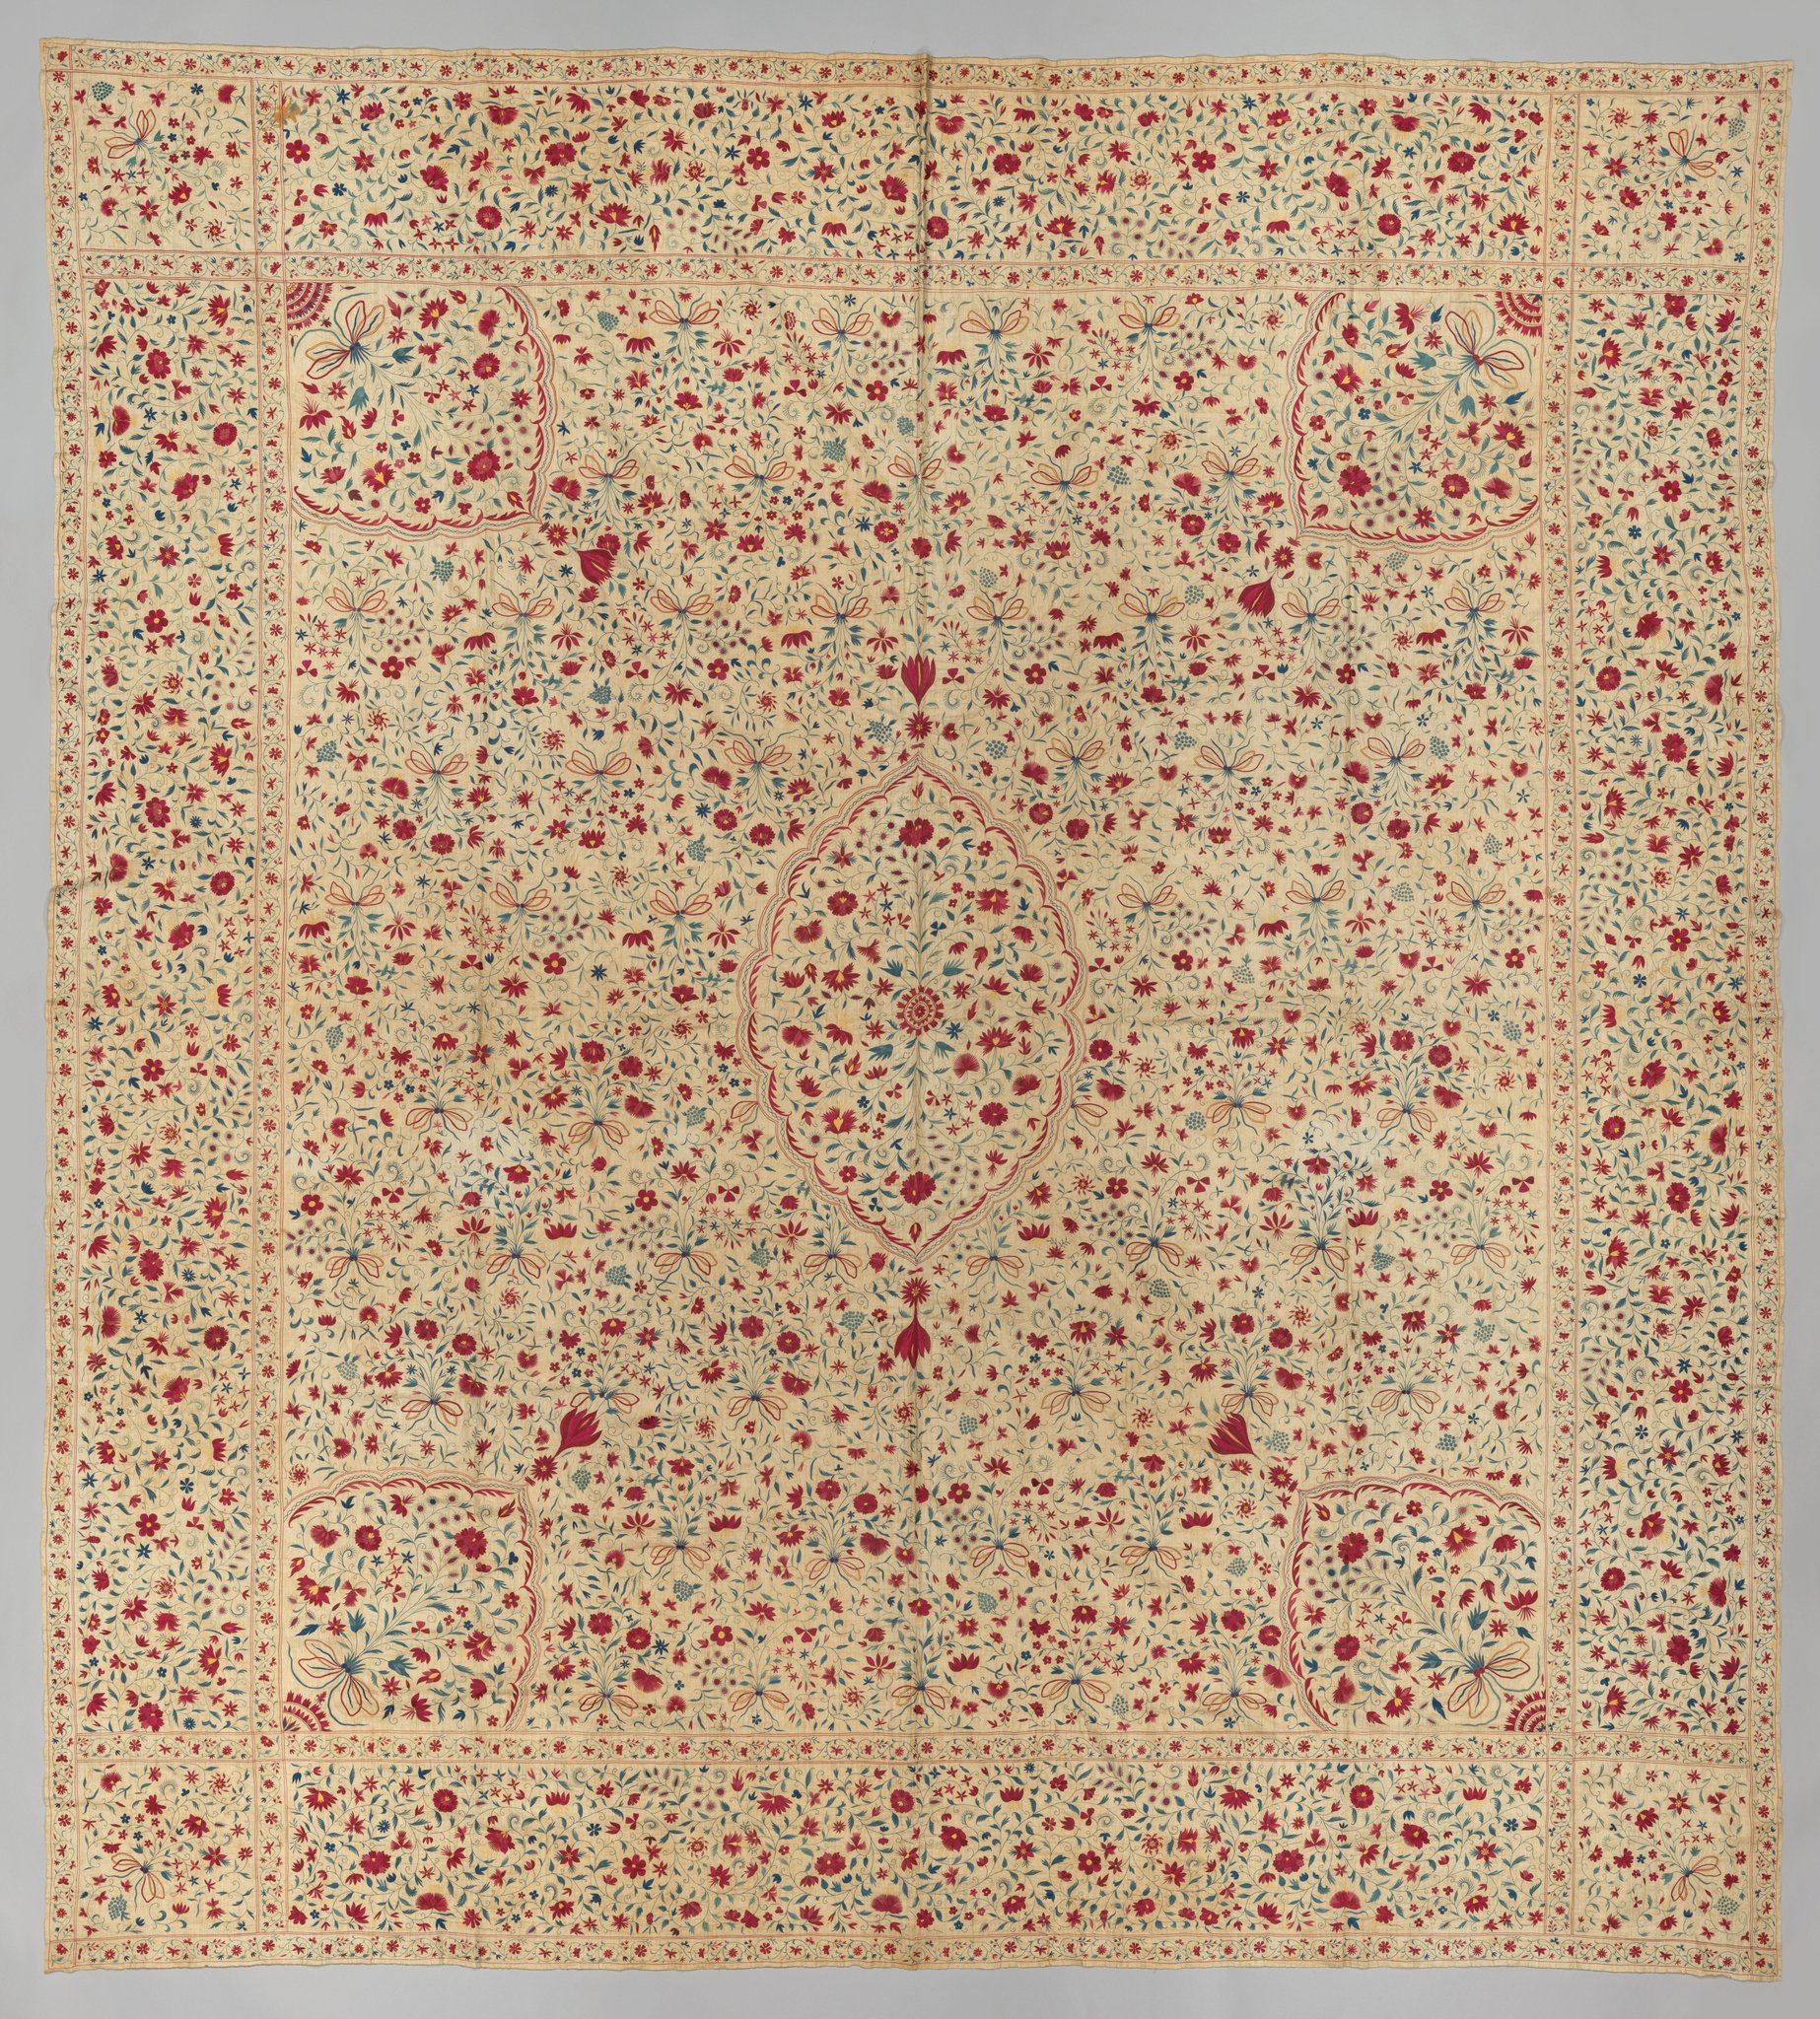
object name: bedspread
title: Veelkleurig getamboereerde sprei van katoen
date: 1700-1750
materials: cotton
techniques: tambouring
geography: east indies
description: Katoenen veelkleurige getamboereerde sprei, versierd met gestrikte bloemboeketten en bloemtakken met een middenmedaillion en hoekversieringen in het middenveld, Indo-Perzisch, gemerkt met een A.